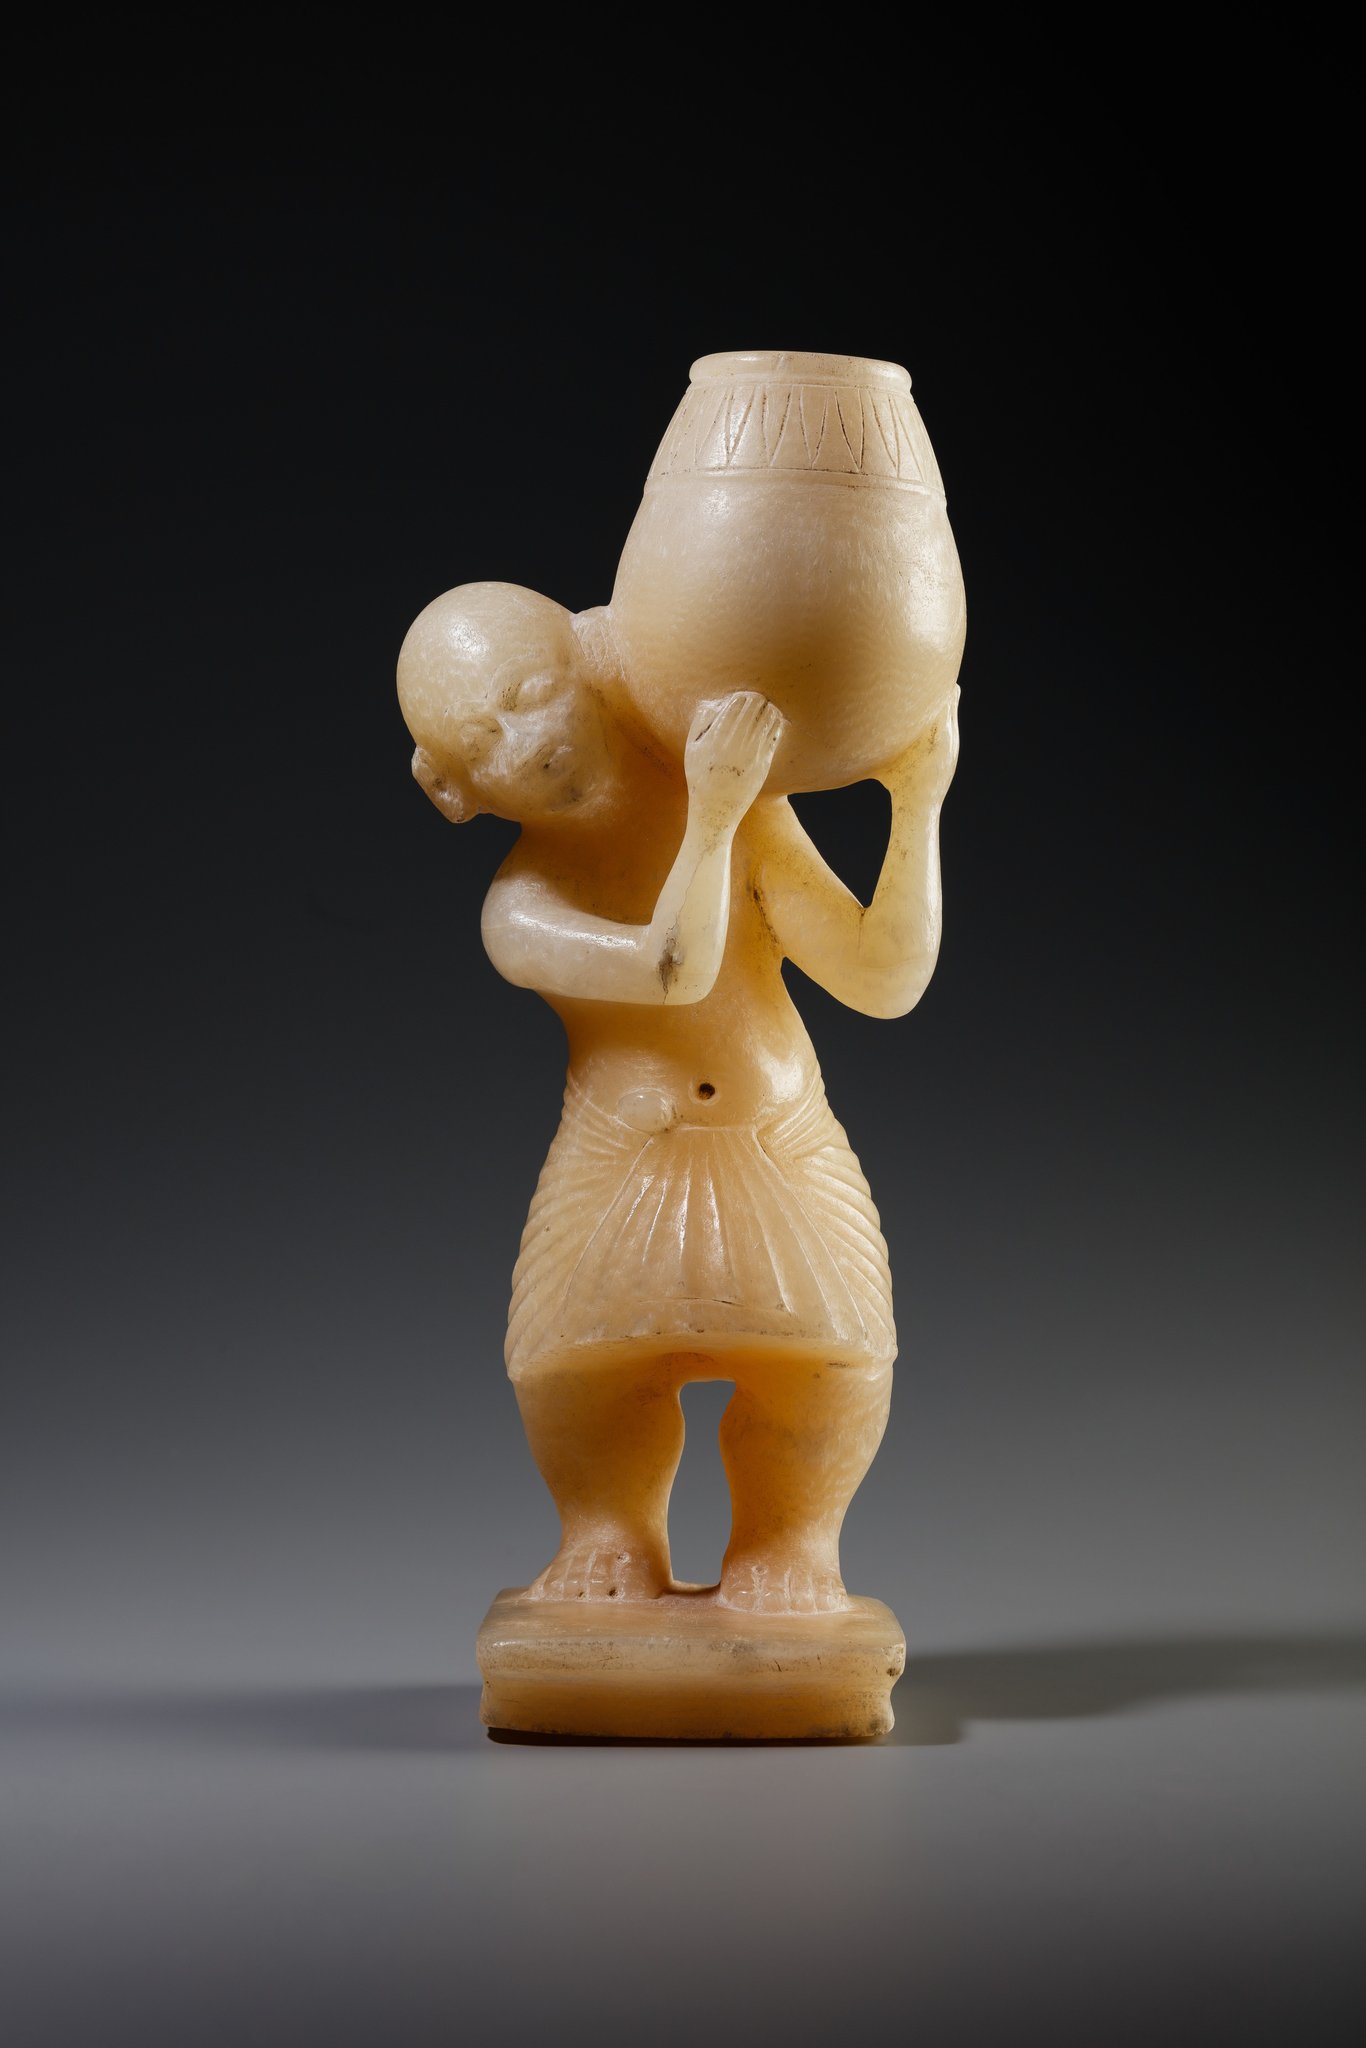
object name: cosmetic jar, dwarf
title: Cosmetic Vessel in the Shape of a Dwarf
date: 1353-1323 BCE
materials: stone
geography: middle egypt